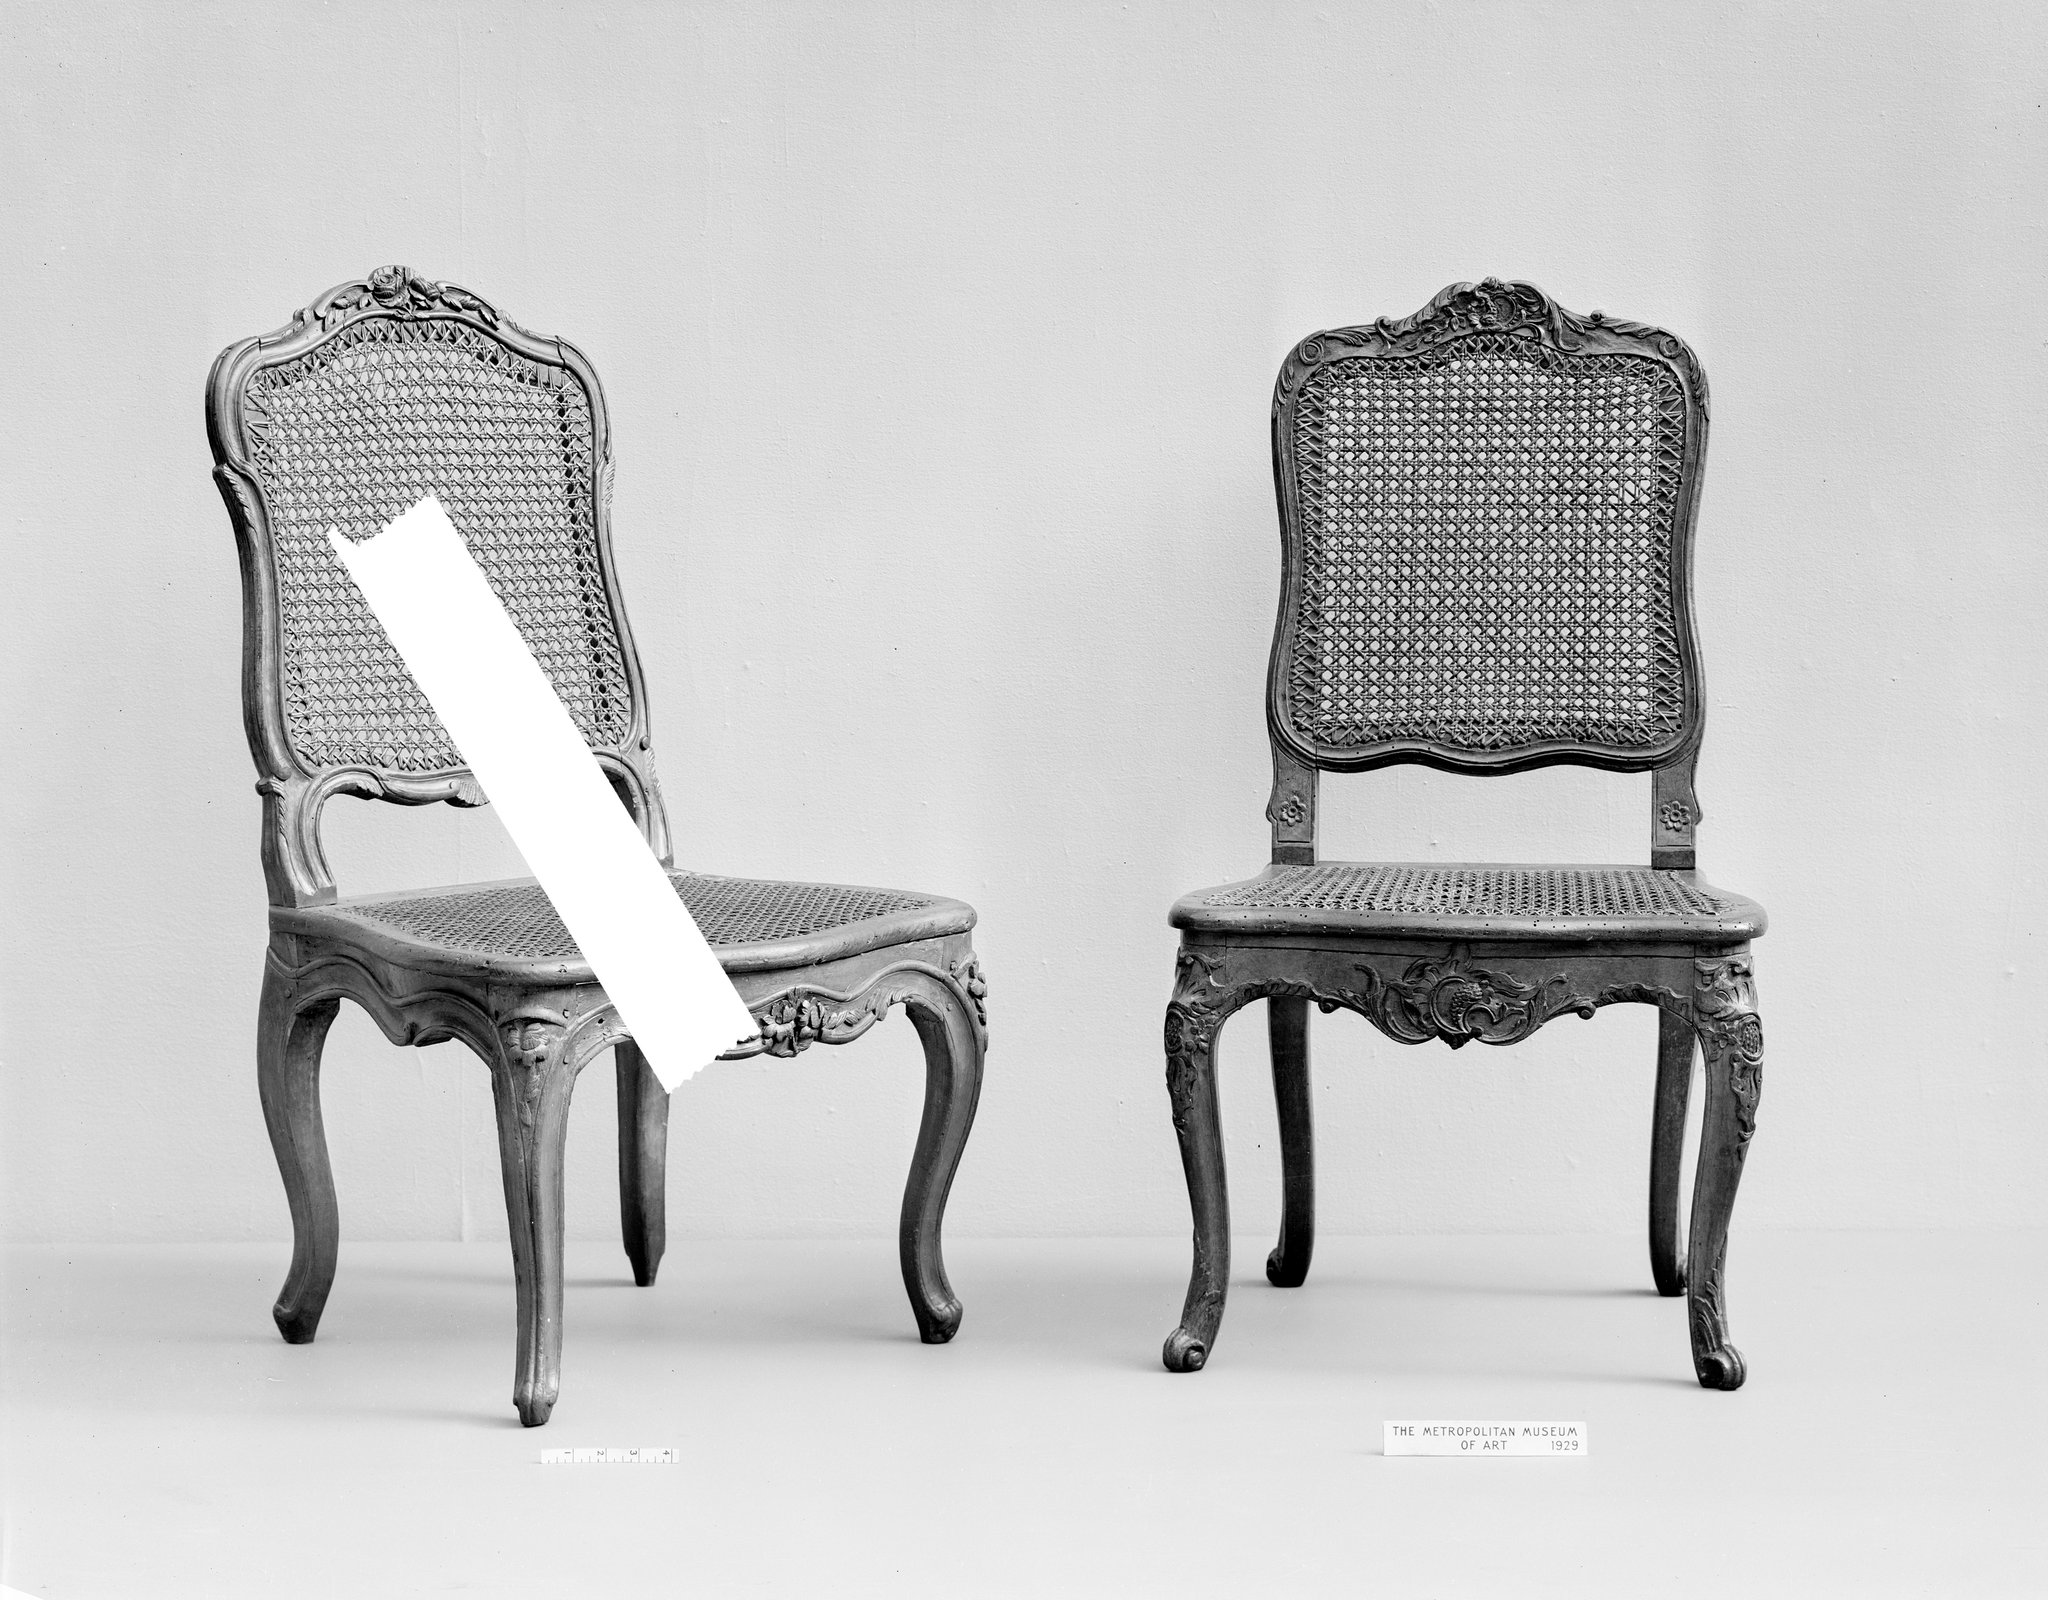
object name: side chair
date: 1726-1750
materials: wood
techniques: carving